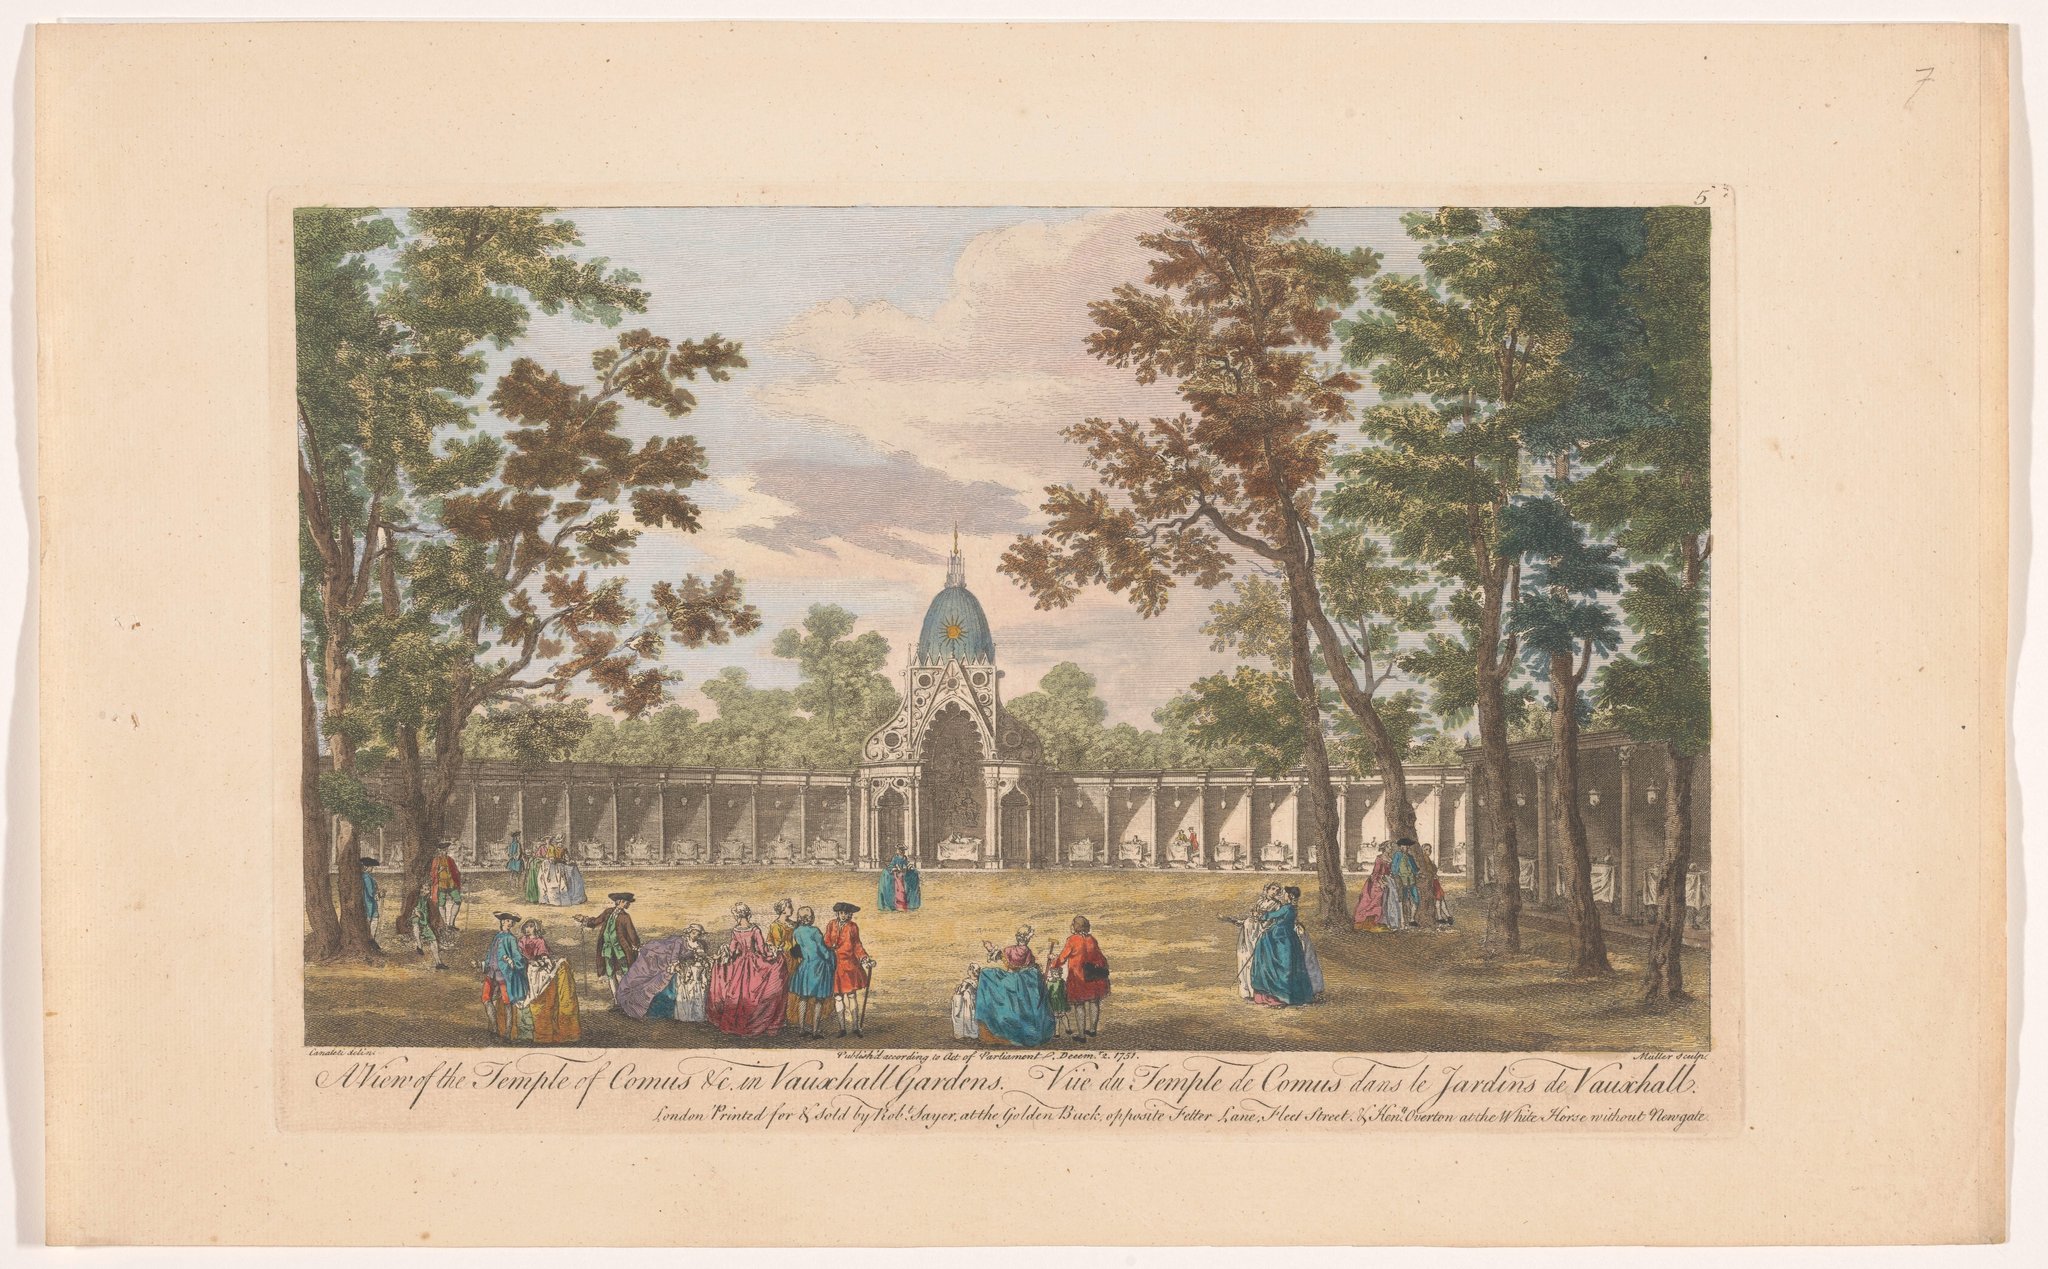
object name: print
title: Ranelagh Gardens en Vauxhall Gardens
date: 1751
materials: paper, watercolor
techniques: brush, etching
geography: london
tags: garden, garden buildings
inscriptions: watermark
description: De serie “Ranelagh Gardens en Vauxhall Gardens” bevat 8 prenten met de nummers 1-8, waarvan dit nummer 7 is.